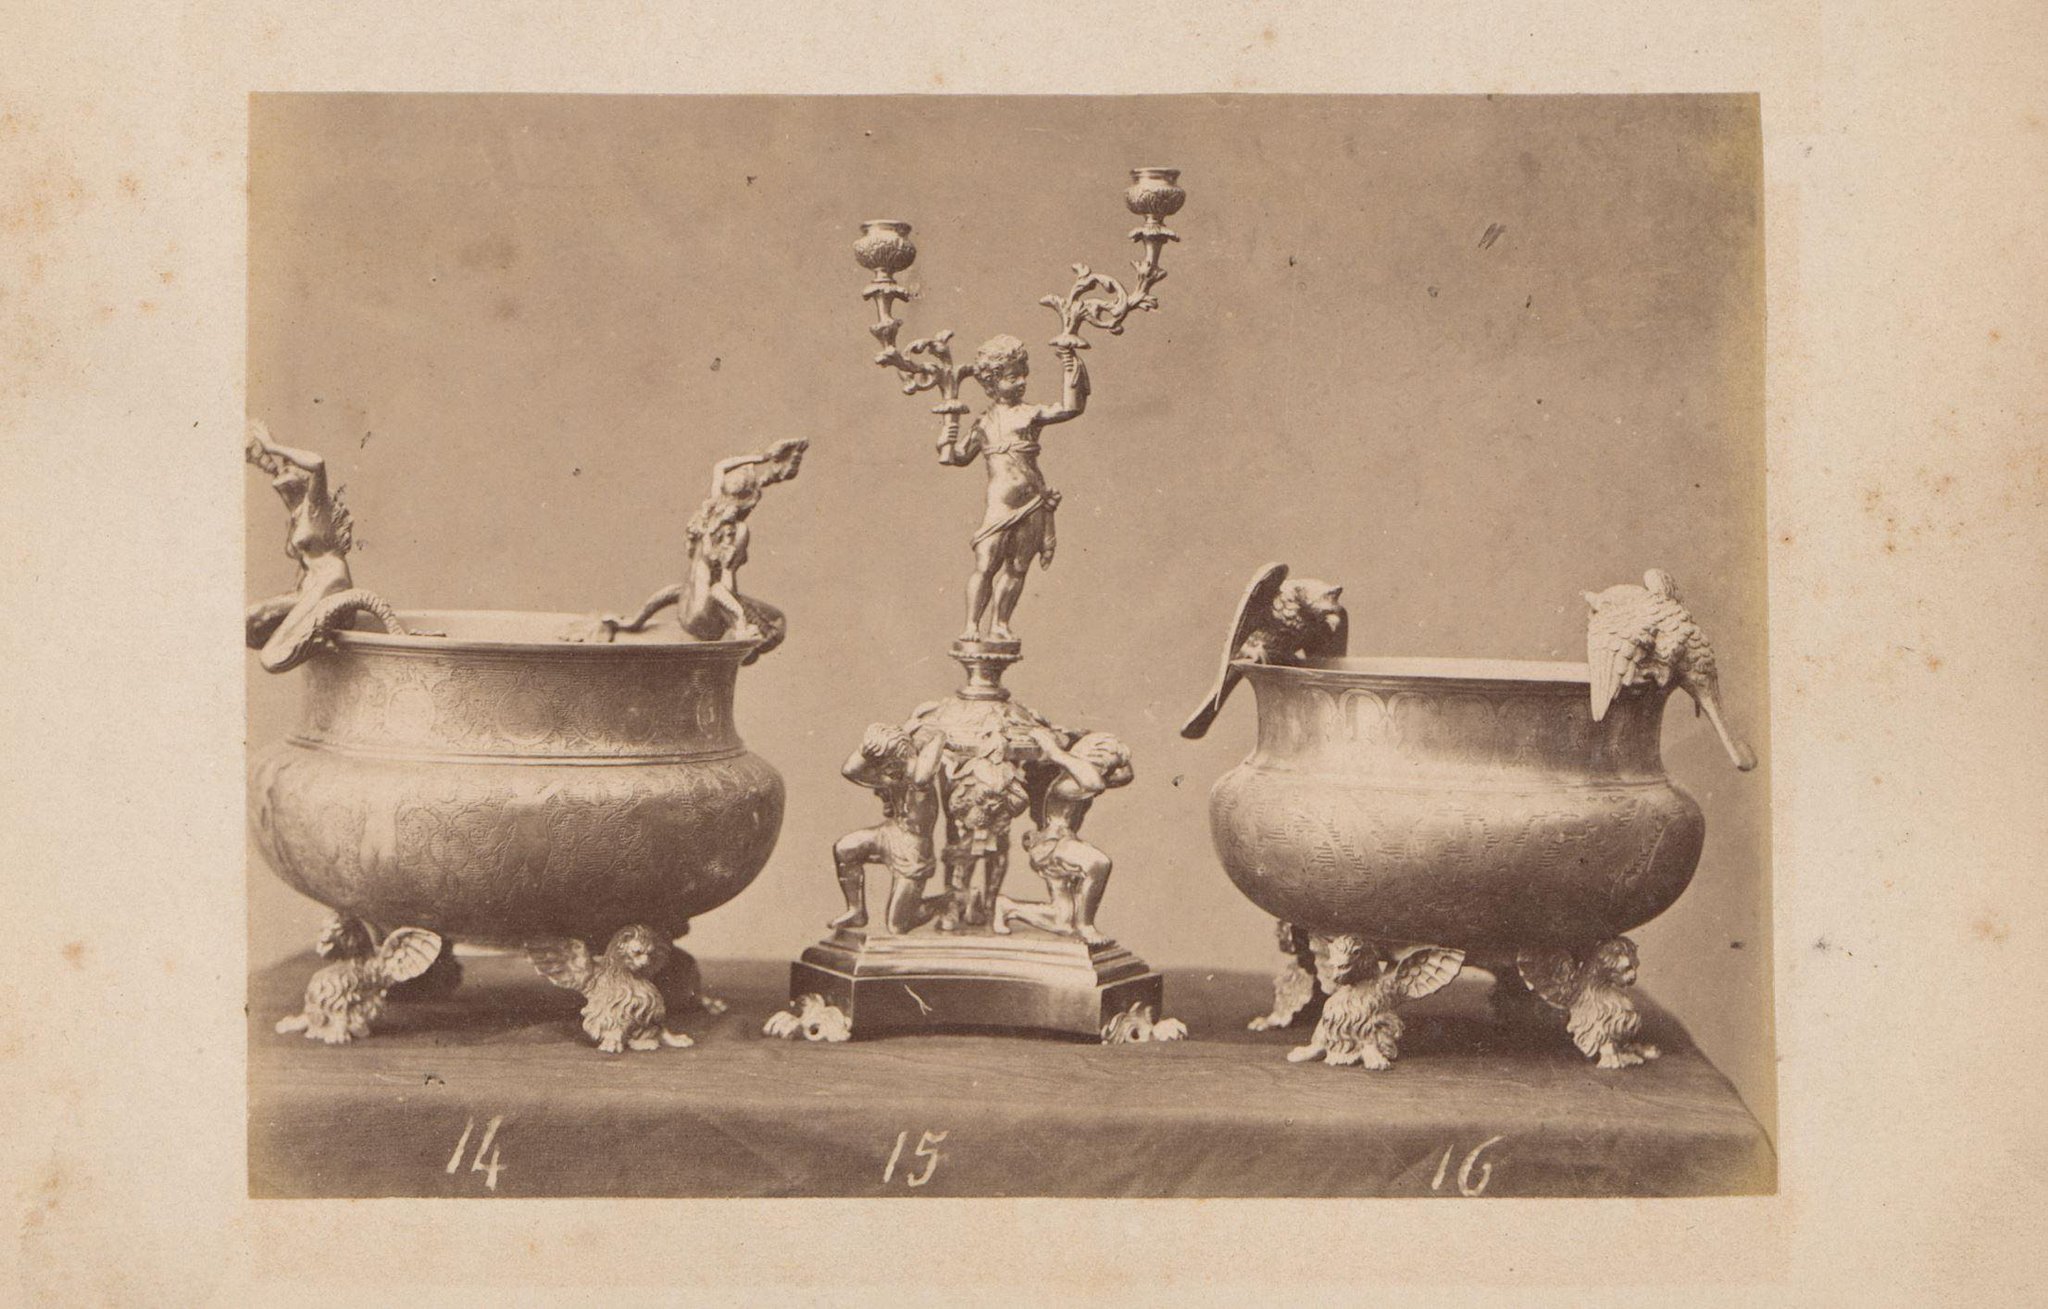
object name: page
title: Metalen vaten en kandelaars voor kerkelijk gebruik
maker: Anonymous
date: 1860-1885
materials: photographic support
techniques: albumen print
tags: containers, chandelier, candelabrum